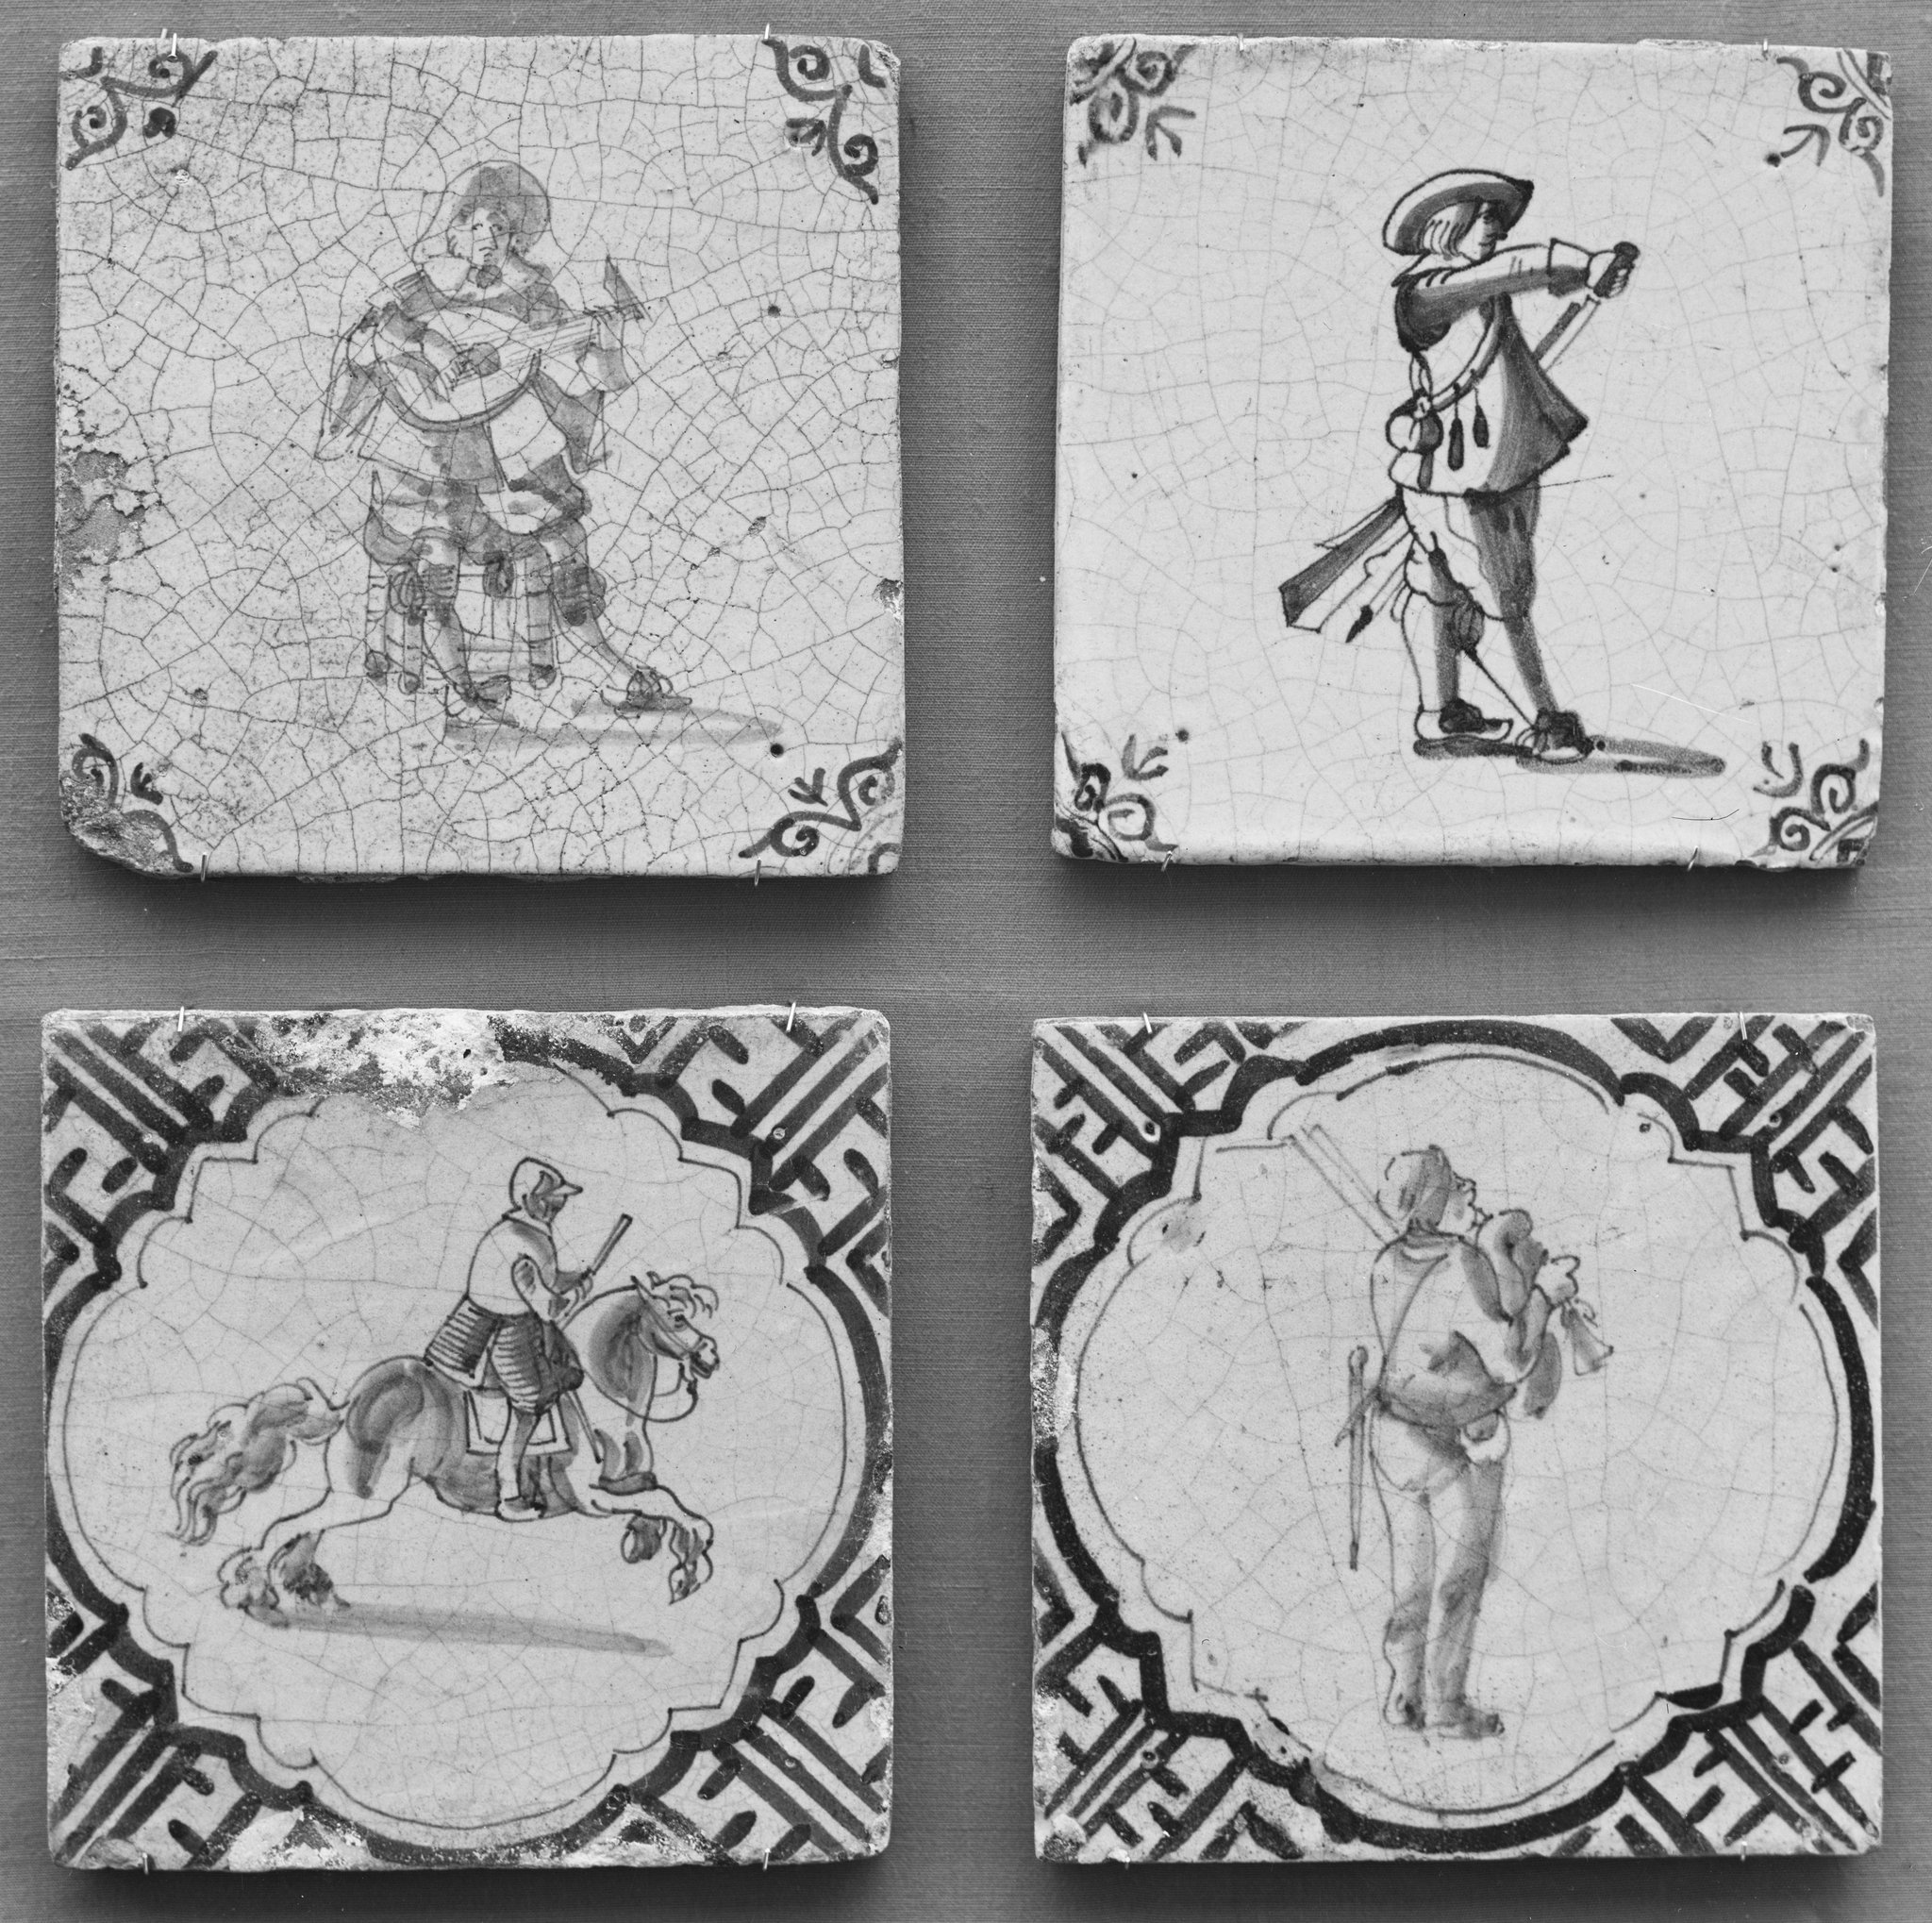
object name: tile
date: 1640-1660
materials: earthenware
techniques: glazing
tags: men,horses